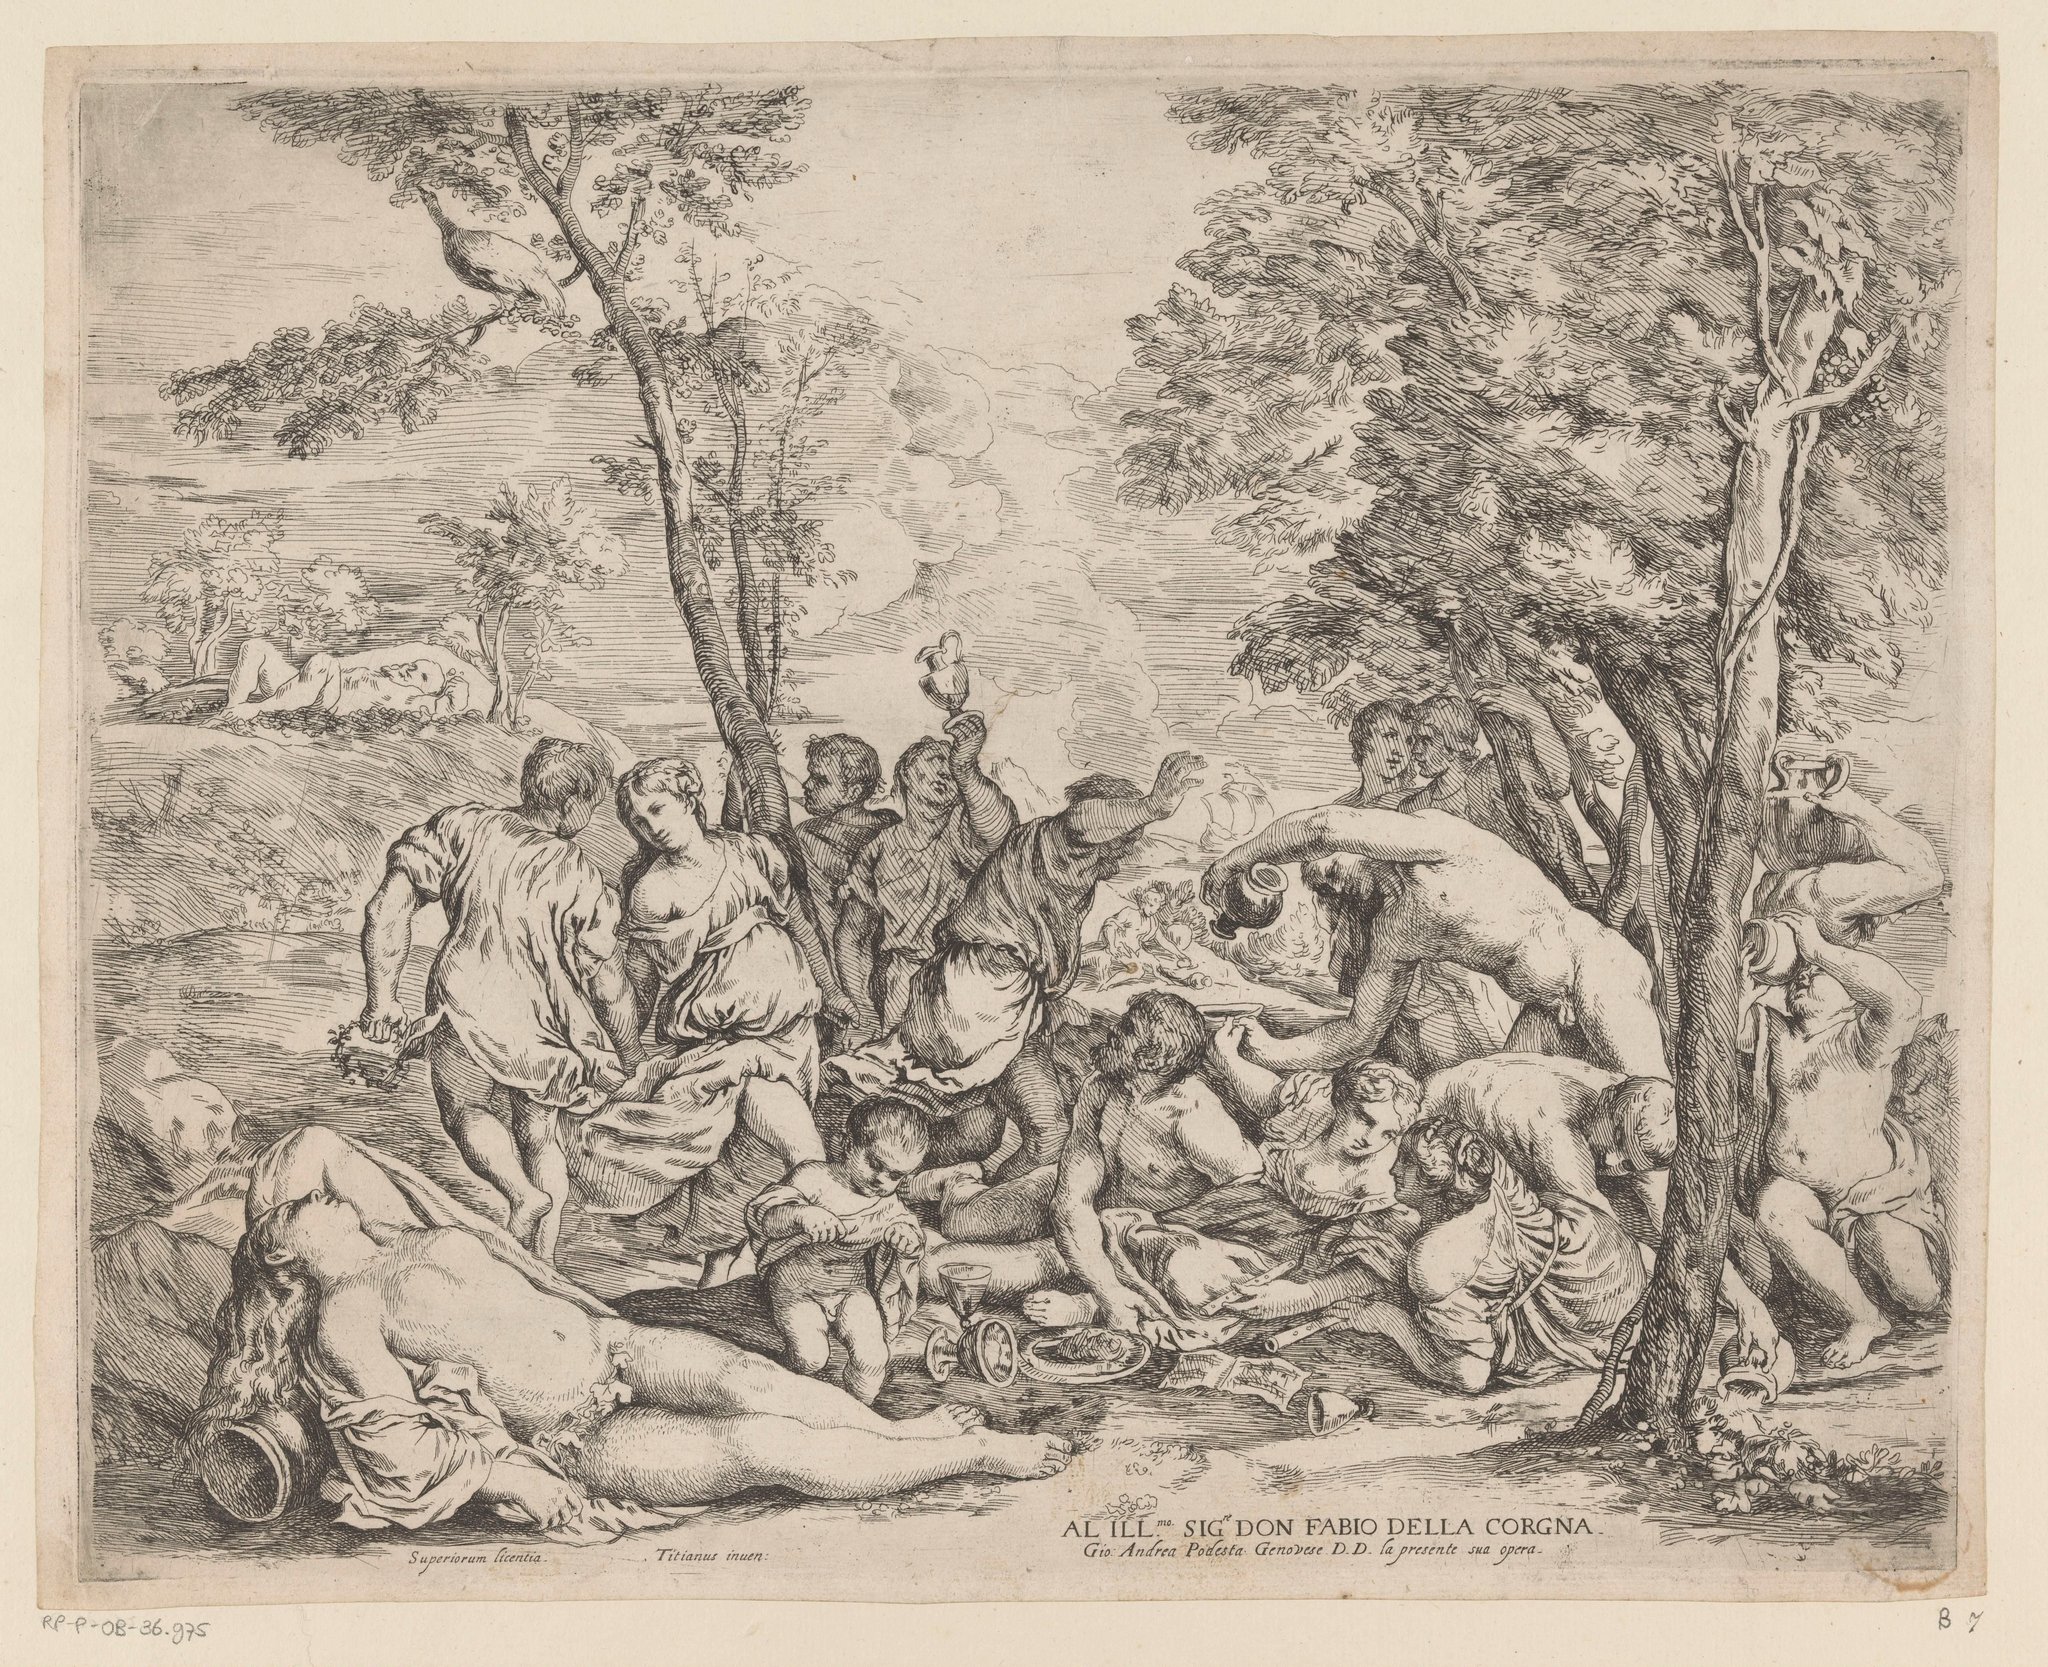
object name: print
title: Bacchanaal op Andros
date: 1618-1674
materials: paper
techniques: etching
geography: genoa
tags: bacchanal of the inhabitants of the island of andros, with bacchus arriving in his ship (philostratus, imagines i 25), sleeping; unconsciousness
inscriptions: collector's mark: Lugt 240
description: Bacchus ontmoet de bewoners van het eiland Andros tijdens een bacchanaal. En groep dronken mannen en vrouwen in een landschap. Op de voorgrond een slapende naakte vrouw.